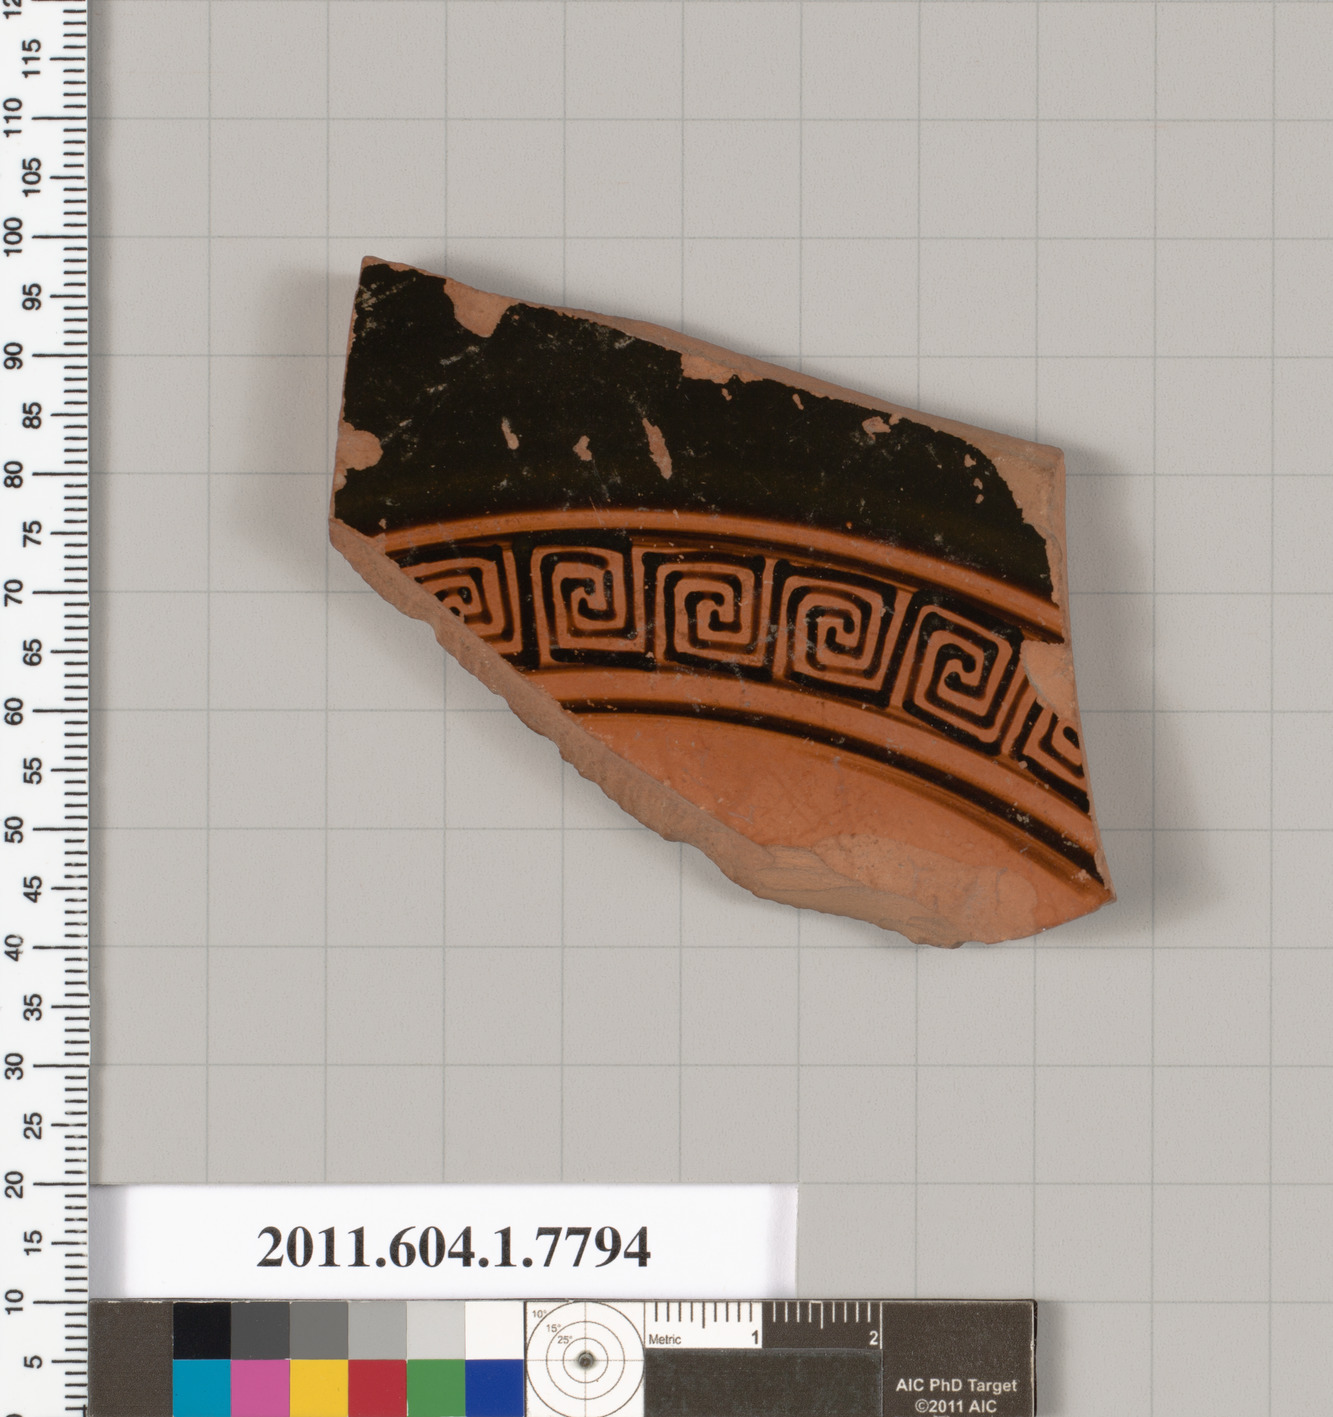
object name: kylix fragment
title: Terracotta fragment of a kylix (drinking cup)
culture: greek, attic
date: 460-450 BCE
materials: terracotta